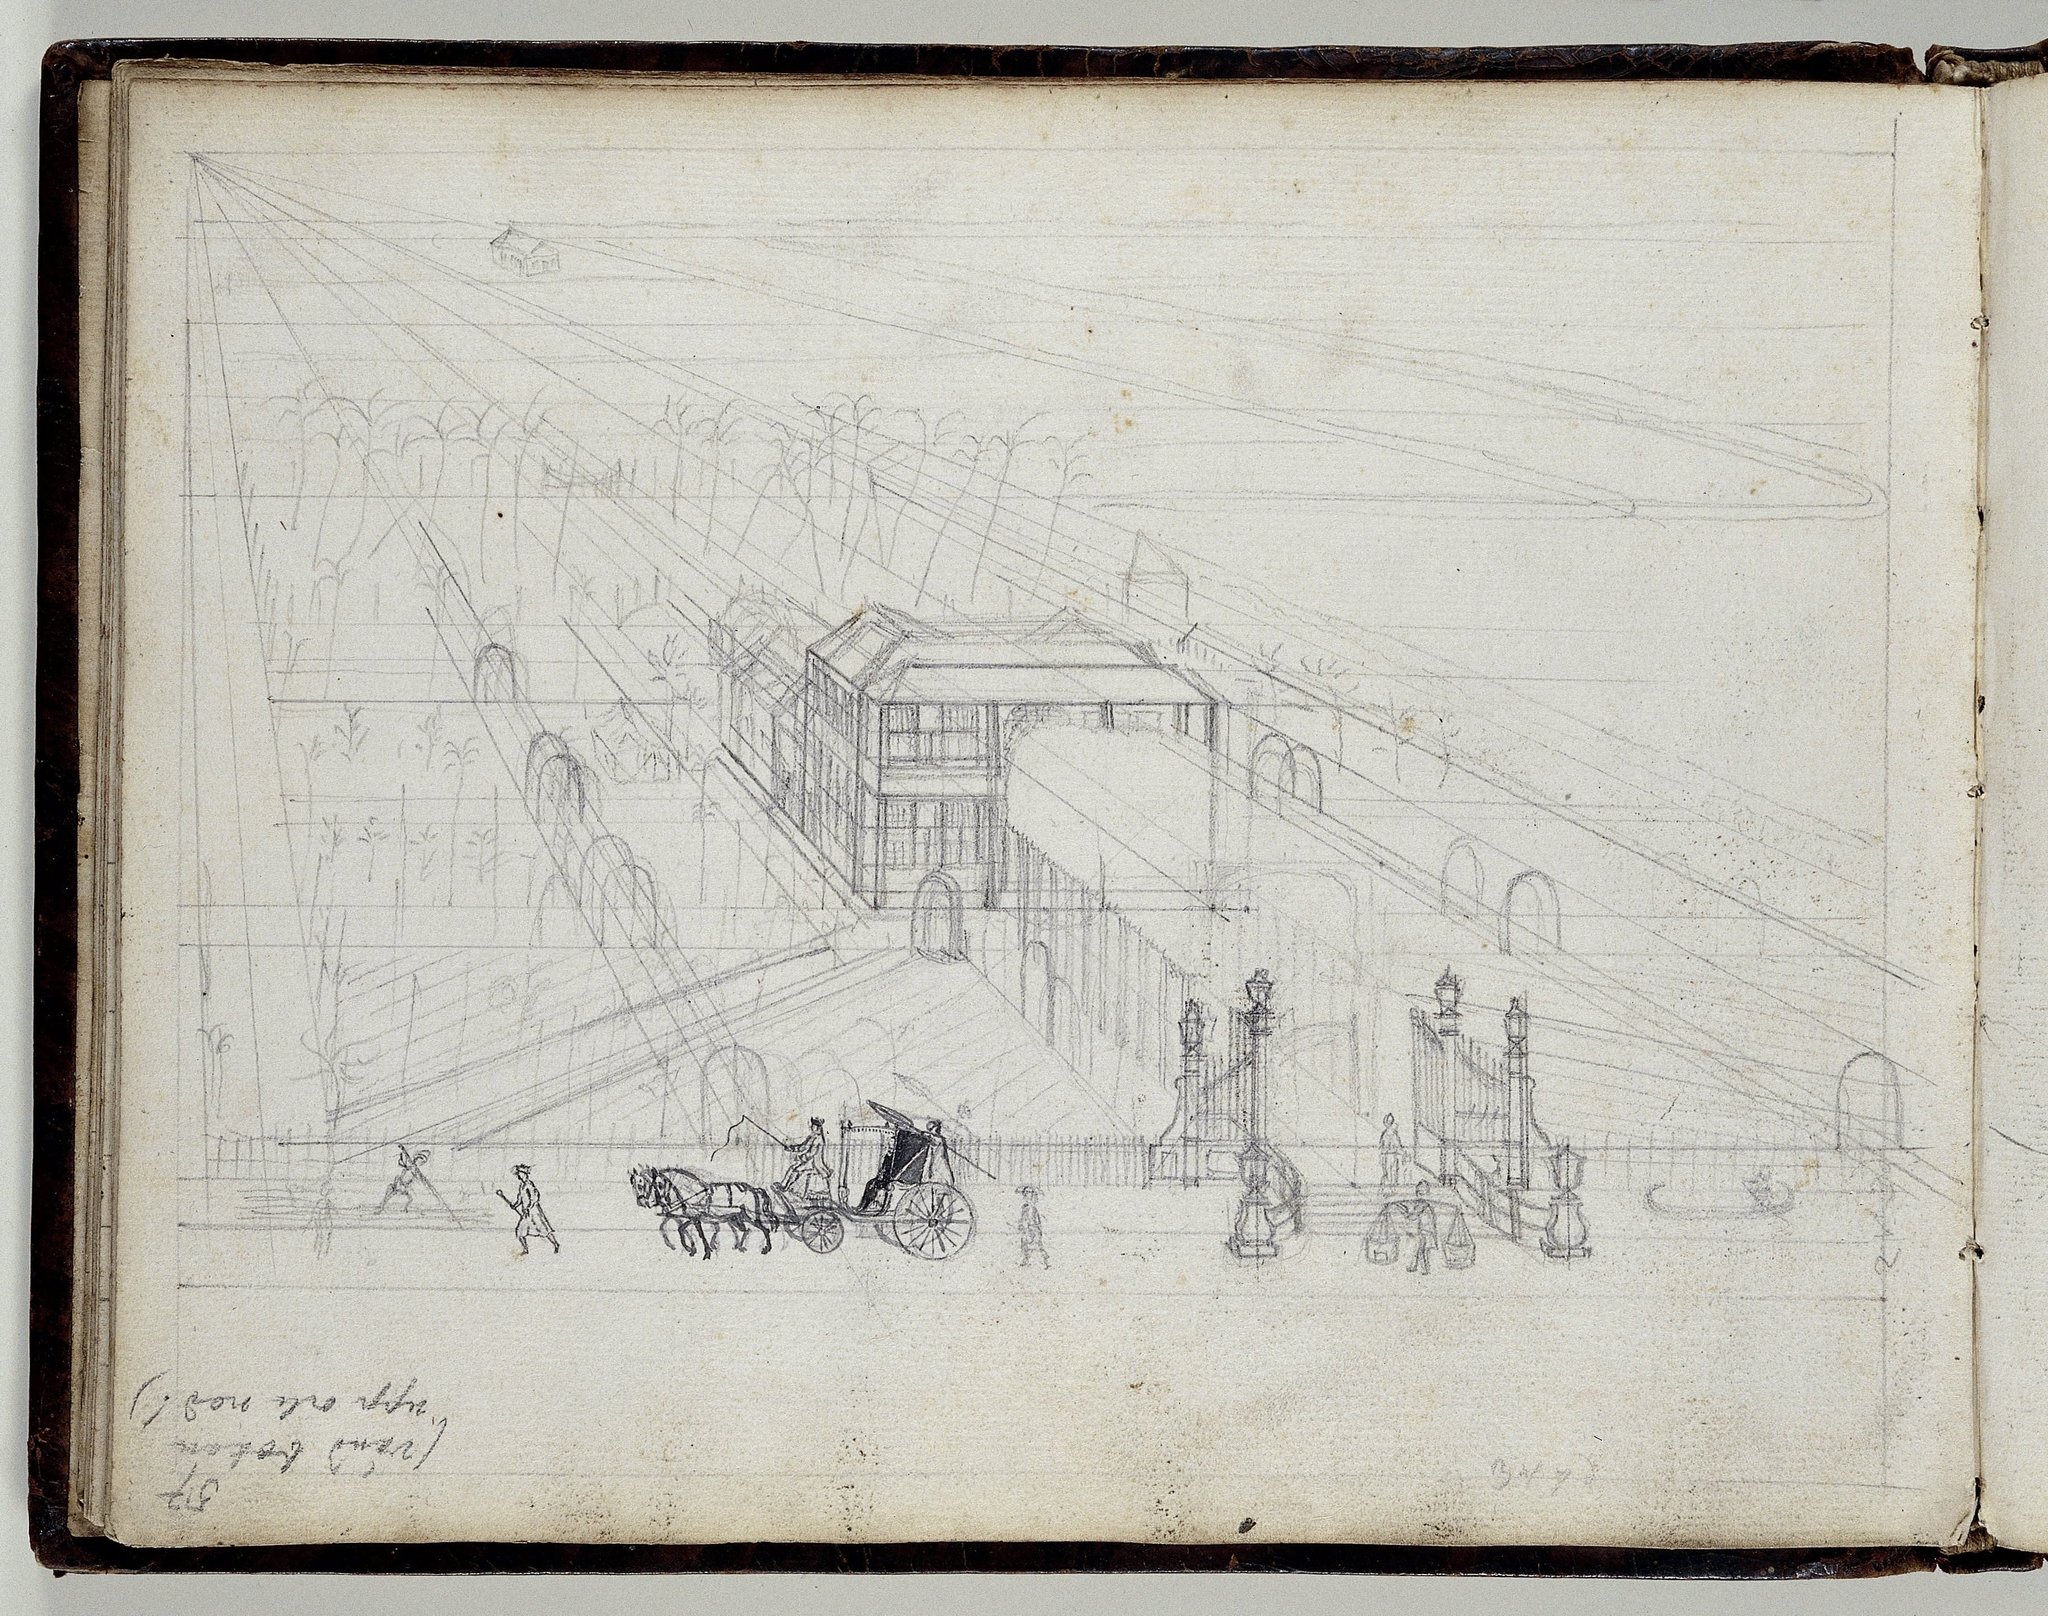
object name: perspective drawing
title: Het landgoed van Brandes bij Batavia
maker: jan brandes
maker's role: draughtsman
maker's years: 1743-1808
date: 1787-1808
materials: paper, pencil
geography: skälsebo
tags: bodegraven, draughtsman, jan brandes, country-house, batavia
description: Perspectiefstudie. Potloodtekening van het huis met tuinen en bijgebouwen van Brandes' huis buiten Batavia van de voorzijde. Over de weg die voor het huis langs loopt, rijdt een rijtuig met passagier en een pajungdrager achterop. Het opschrift is van Kellberg, 20ste eeuwse nazaat van Brandes. Onderdeel uit het grote schetsboek van Jan Brandes 'Perspektivritningar' (1808), p. 57.